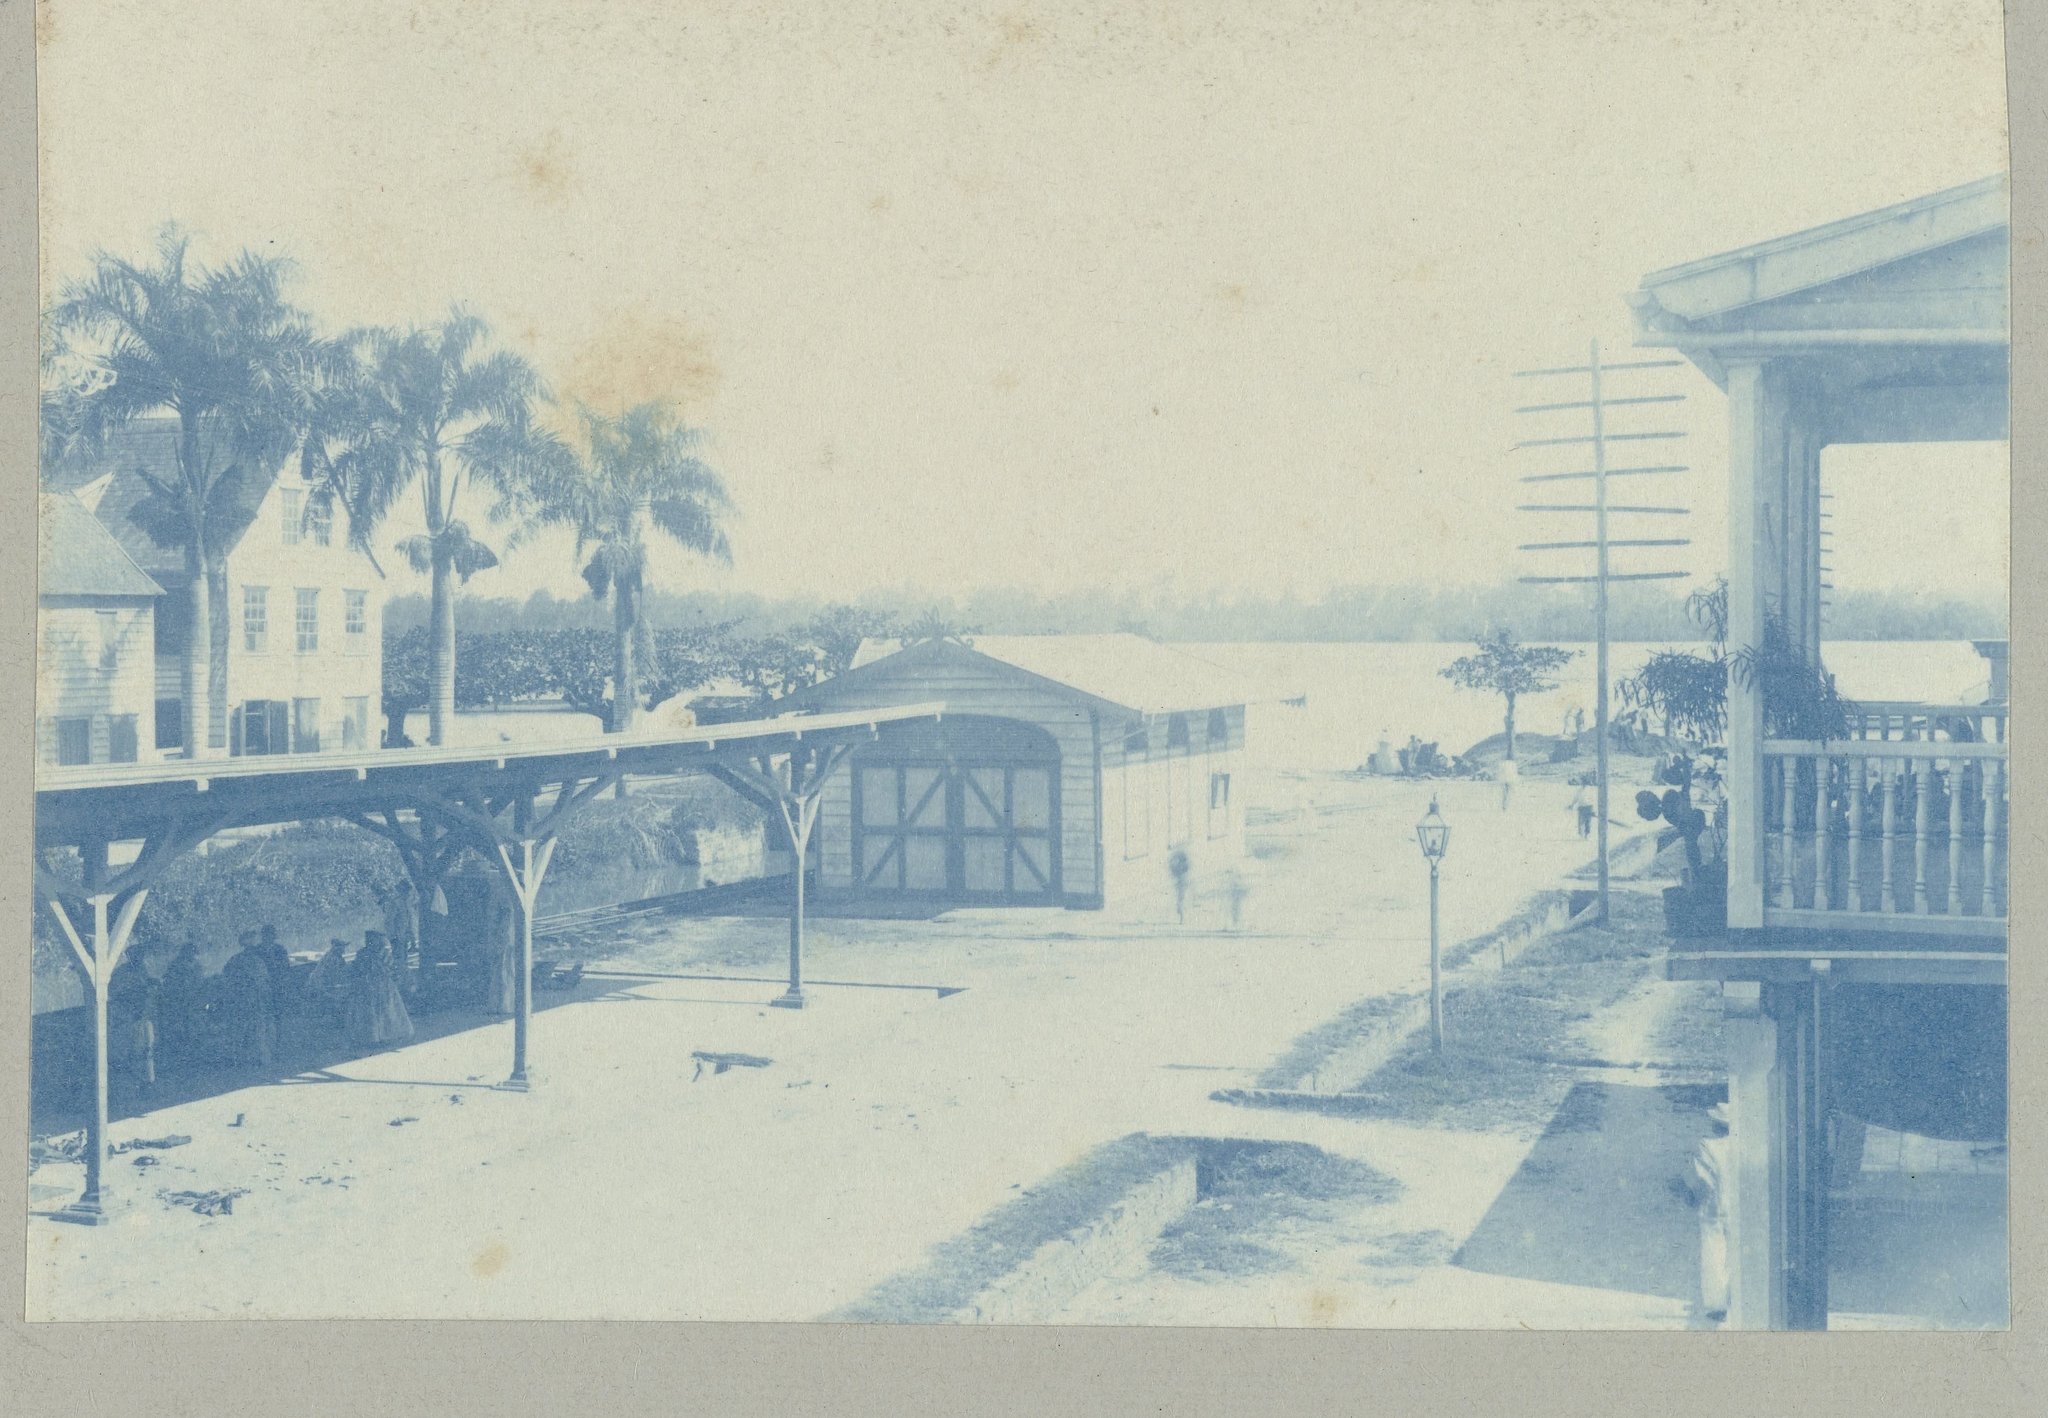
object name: photograph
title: Gezicht uit huis op Heiligenweg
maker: hendrik doijer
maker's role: engineer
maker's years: 1863-1925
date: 1903-1910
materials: photographic support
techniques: cyanotype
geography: suriname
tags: suriname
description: Gezicht op de Heiligenweg met overdekte passage, te Paramaribo. Onderdeel van het fotoalbum Souvenir de Voyage (deel 2), over het leven van de familie Doijer in en rond de plantage Ma Retraite in Suriname in de jaren 1903-1910.